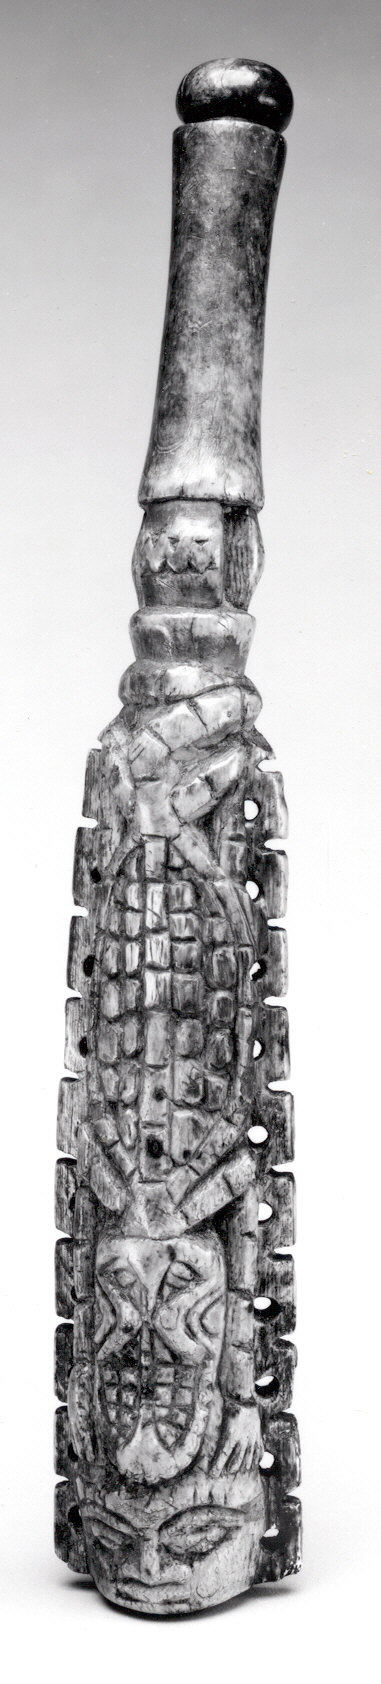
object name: rattle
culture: yoruba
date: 1701-1900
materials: ivory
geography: nigeria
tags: musical instruments,faces